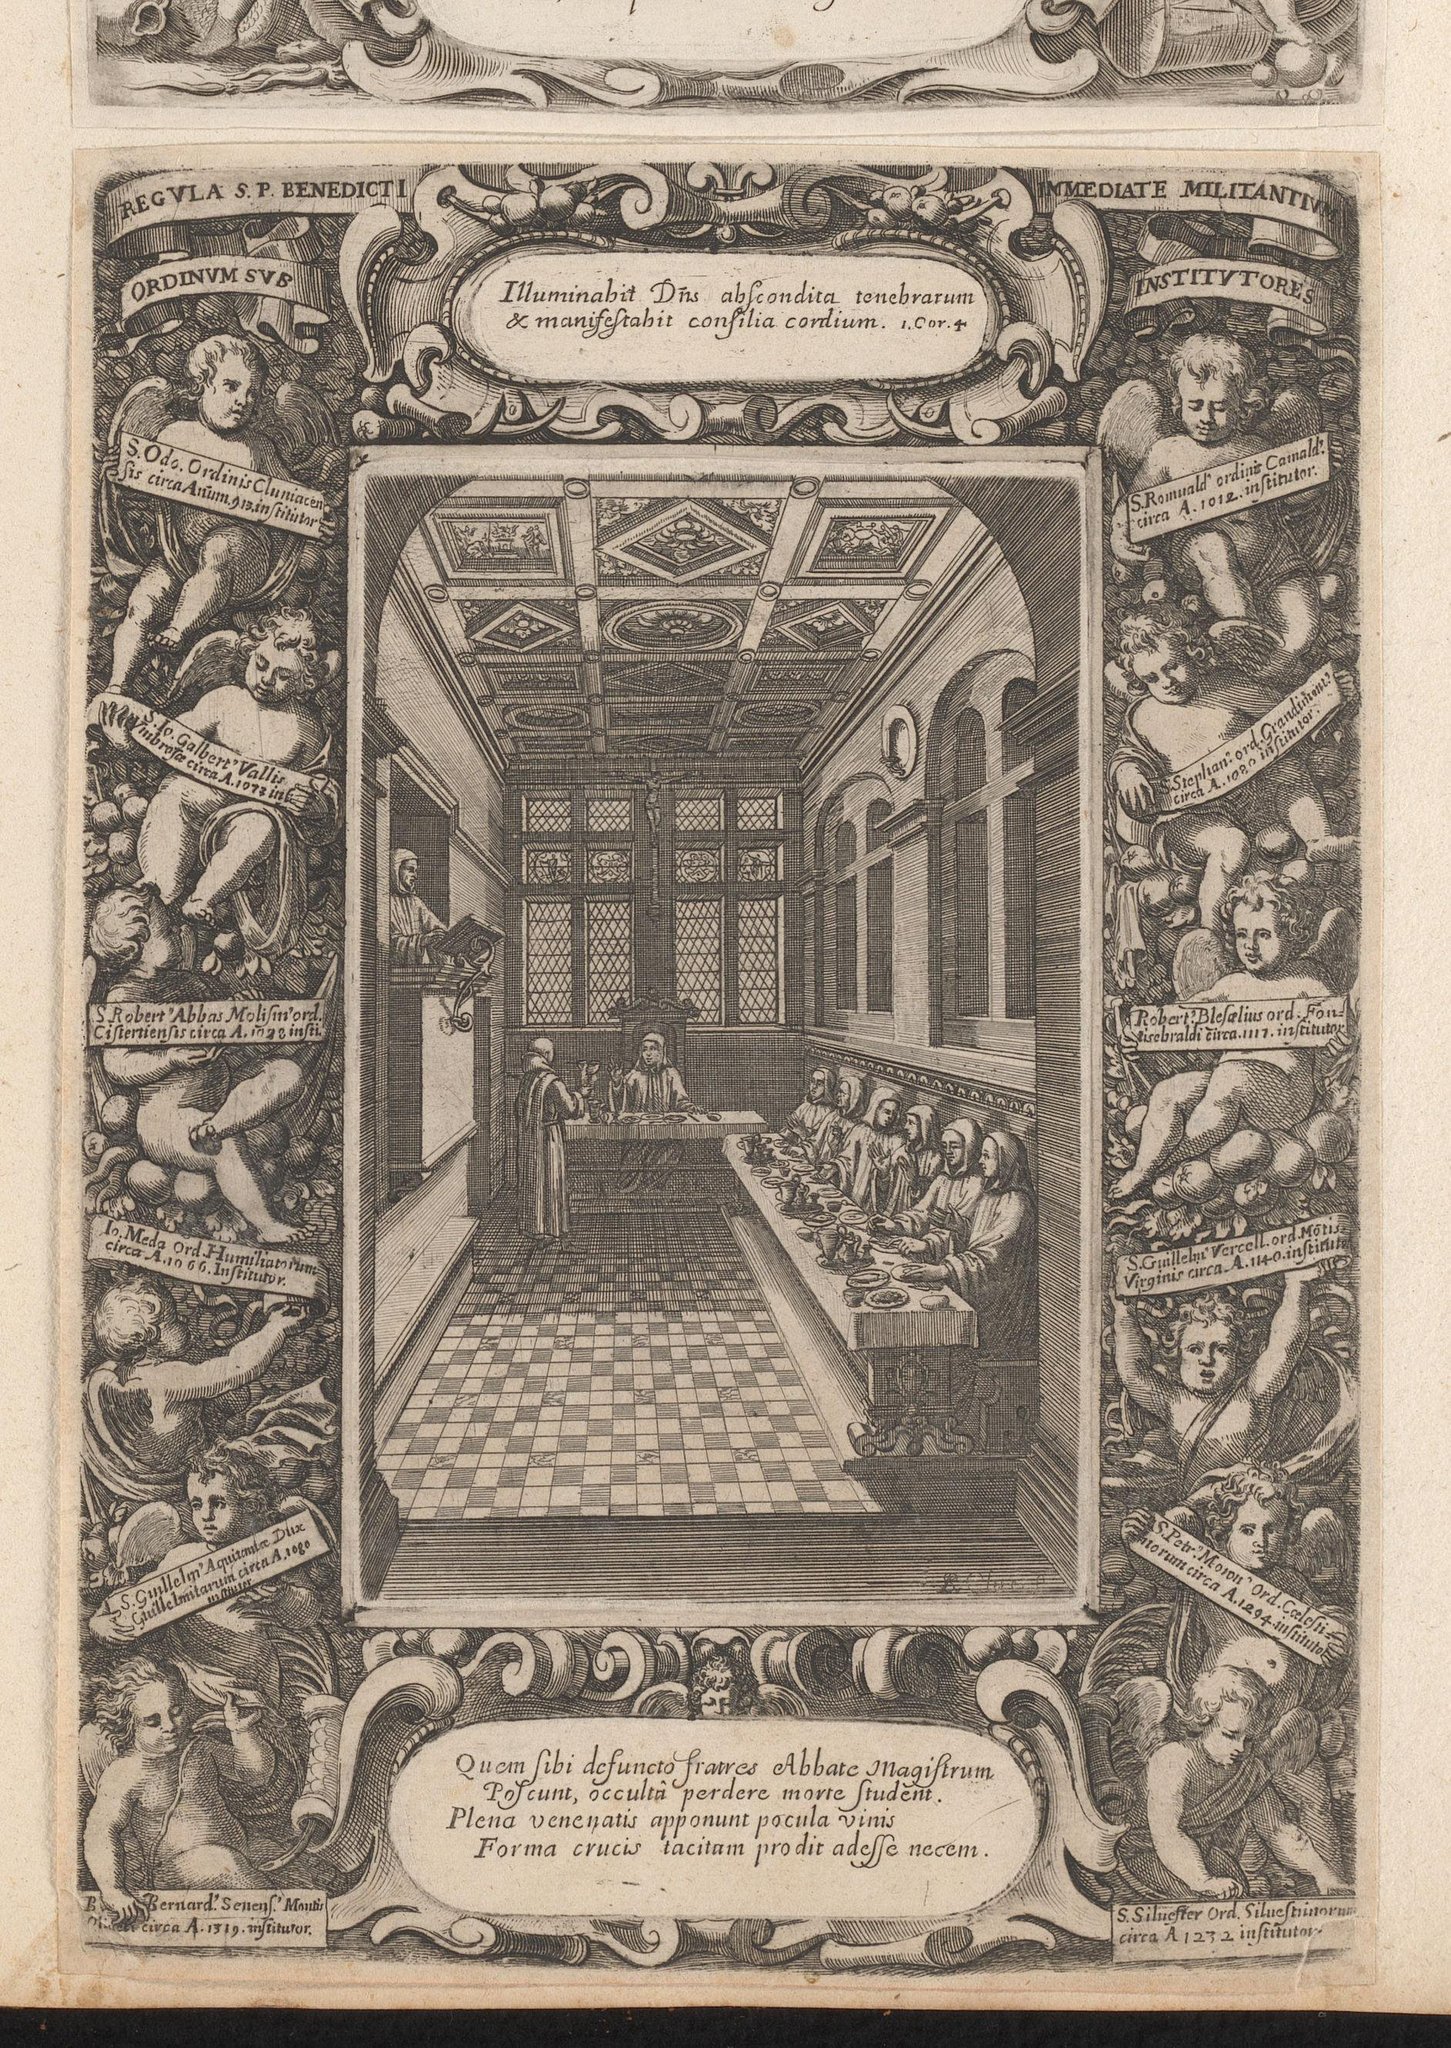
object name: album leaf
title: Scènes uit het leven van H. Benedictus van Nursia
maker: sébastien leclerc (i)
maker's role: print maker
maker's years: 1637-1714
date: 1658-1659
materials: paper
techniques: etching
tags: st. benedict blesses a cup with poisoned wine; the cup breaks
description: Maakt deel uit van een serie bestaande uit 33 prenten met voorstellingen uit het leven van de Heilige Benedictus van Nursia in ornamentele cartouches, uitgegeven in 1658-1659. De prenten zijn gedrukt van drie afzonderlijke platen bestaande uit de voorstelling, de cartouche en de tekst.